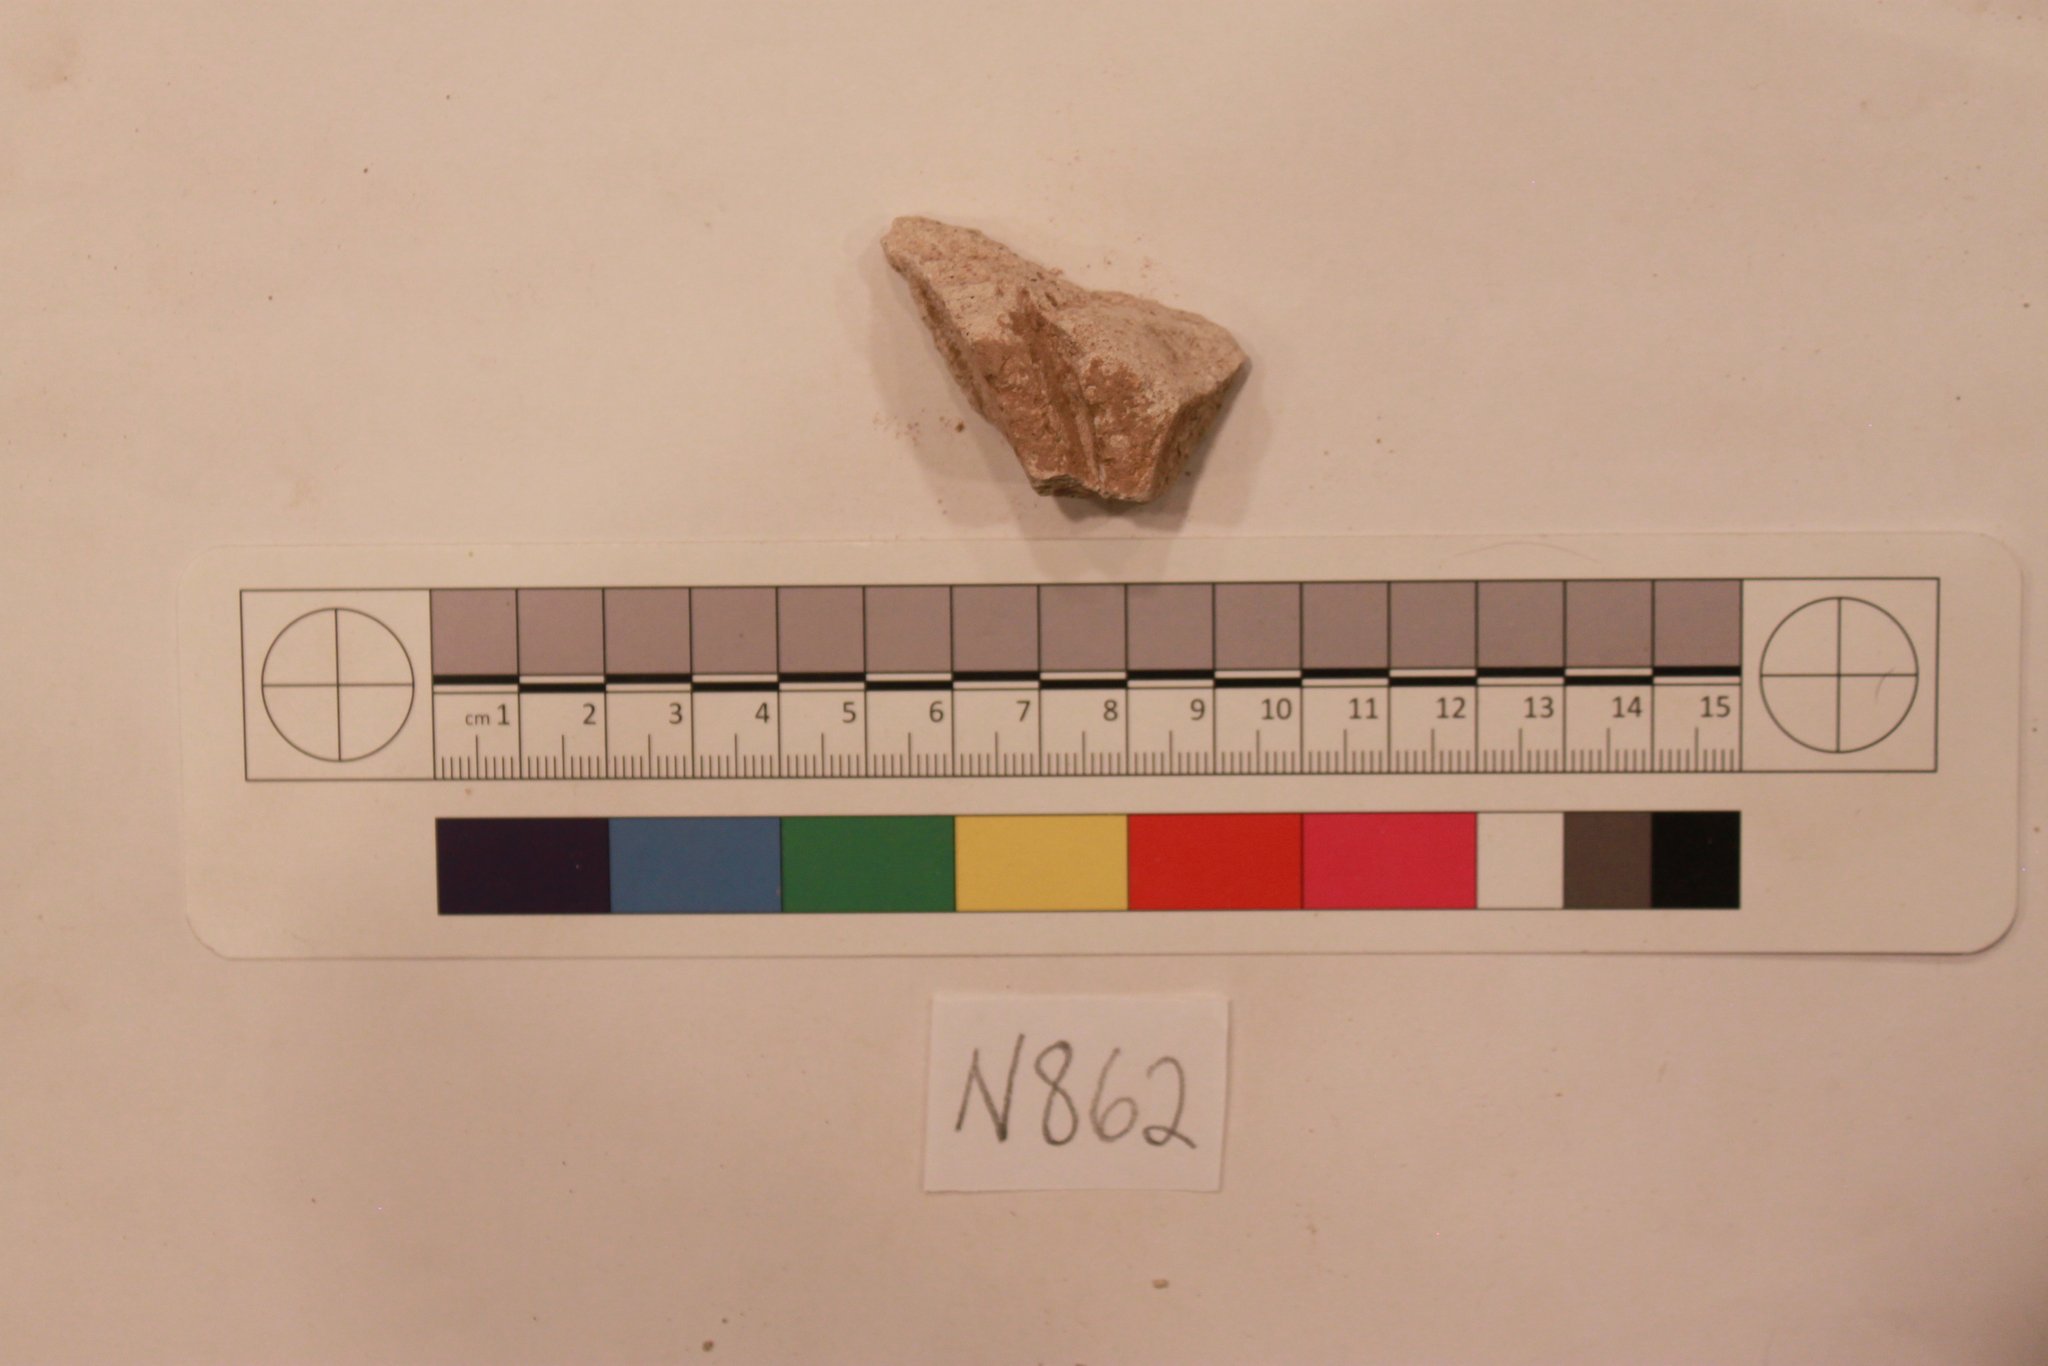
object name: fragment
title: Stucco Fragment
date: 701-1200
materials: plaster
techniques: carving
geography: iran